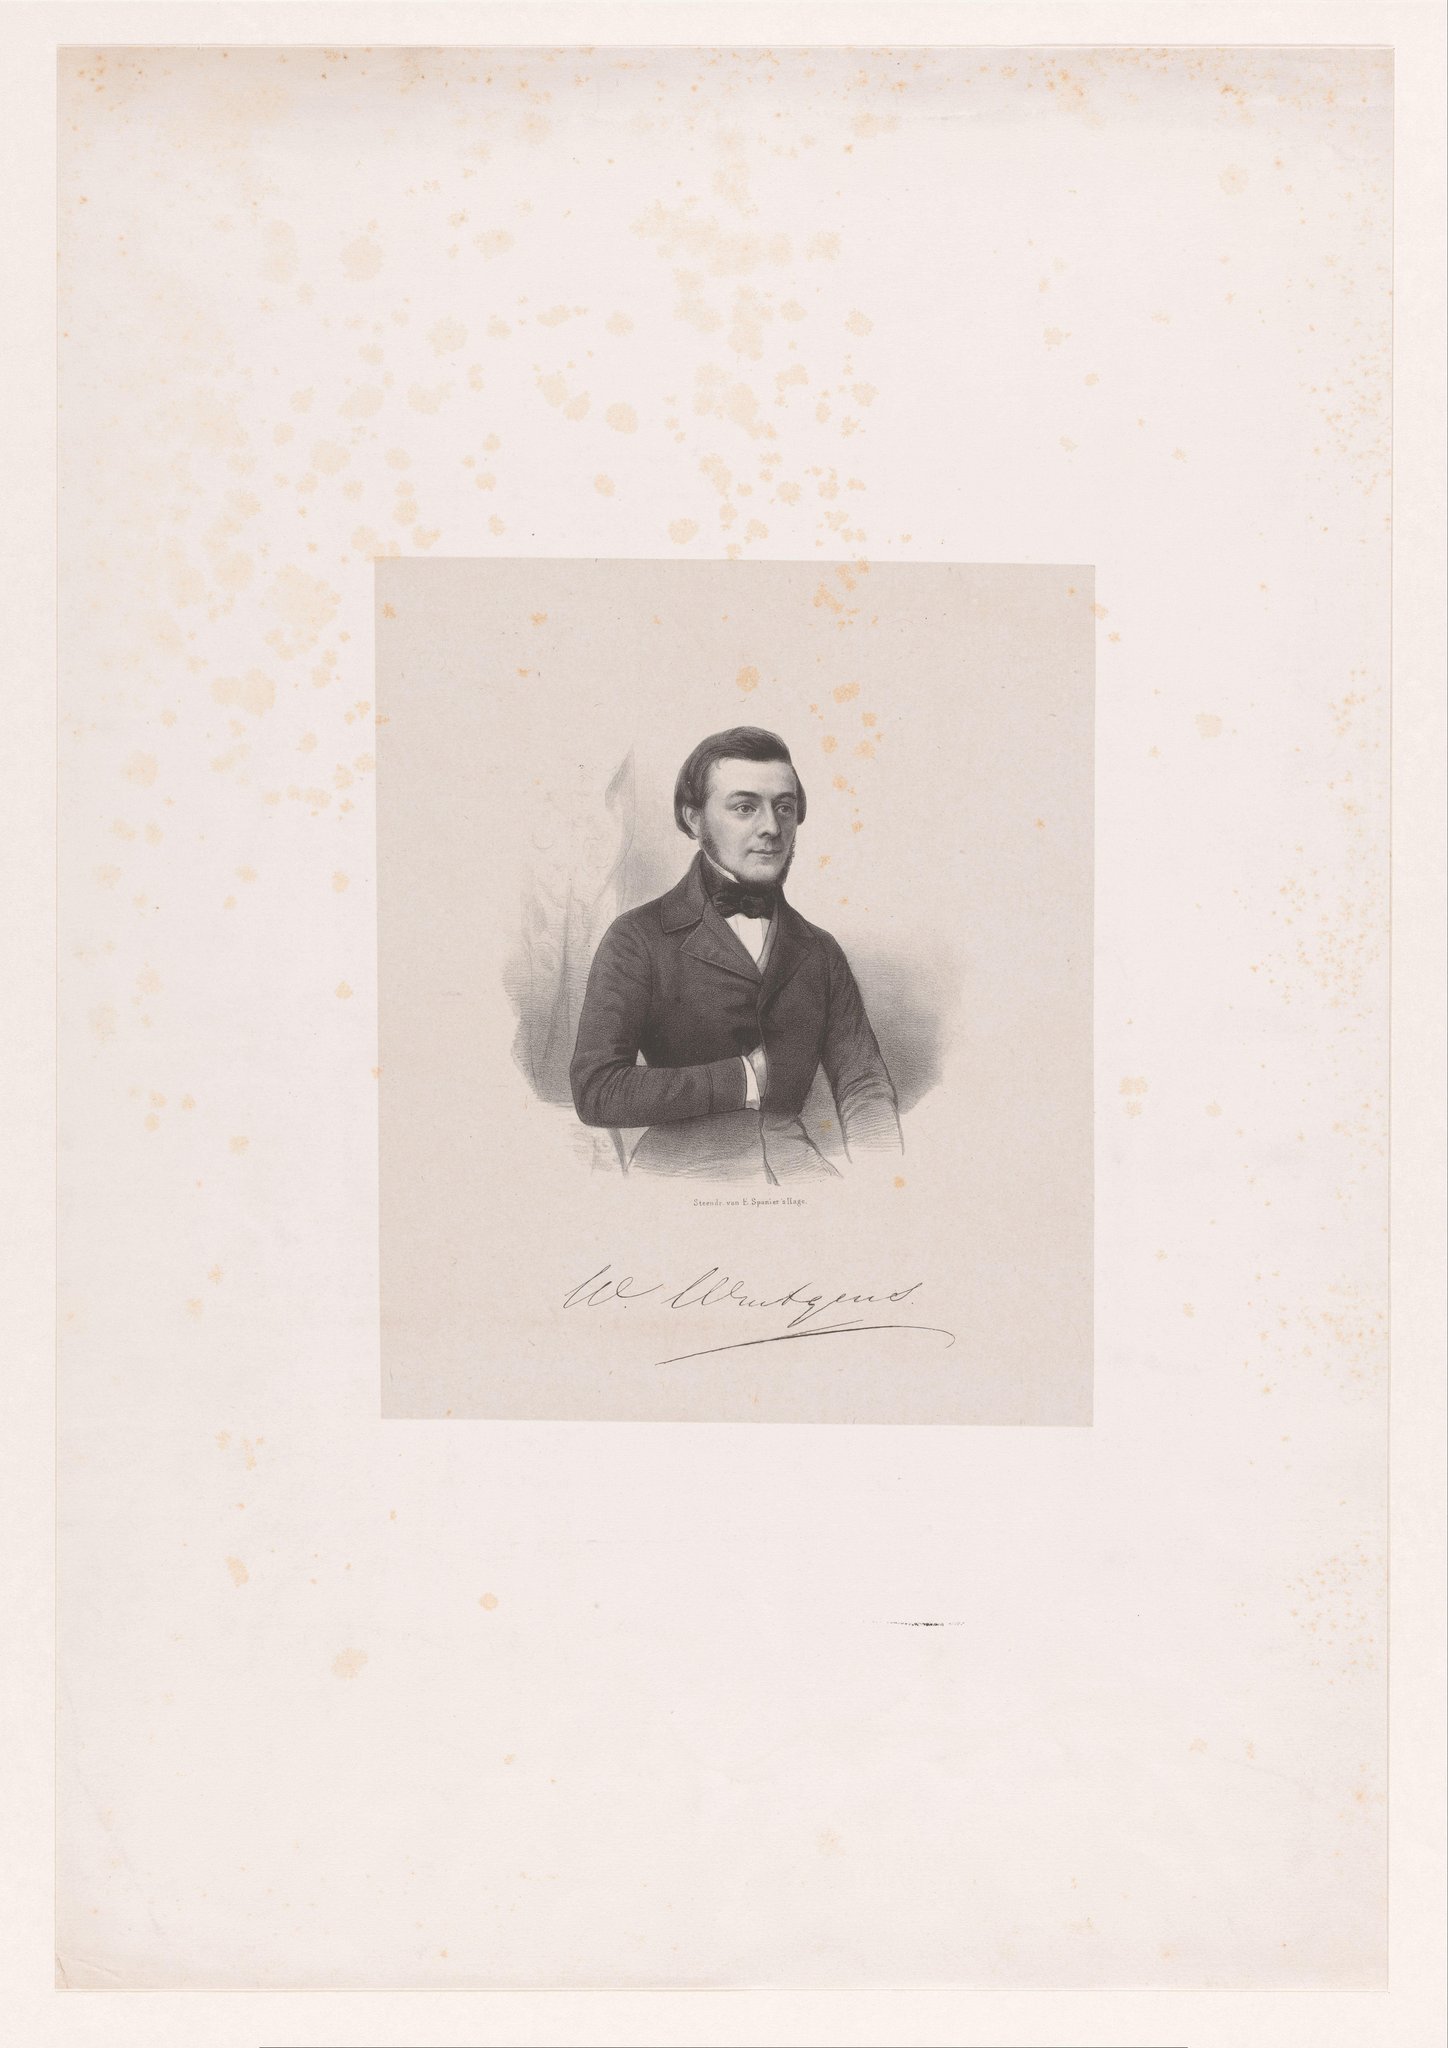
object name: print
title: Portret van Willem Wintgens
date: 1831-1863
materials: paper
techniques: lithograph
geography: the hague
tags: the hague, politician, historical persons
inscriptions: collector's mark: Lugt 2228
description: Onder het portret de signatuur van de geportretteerde.